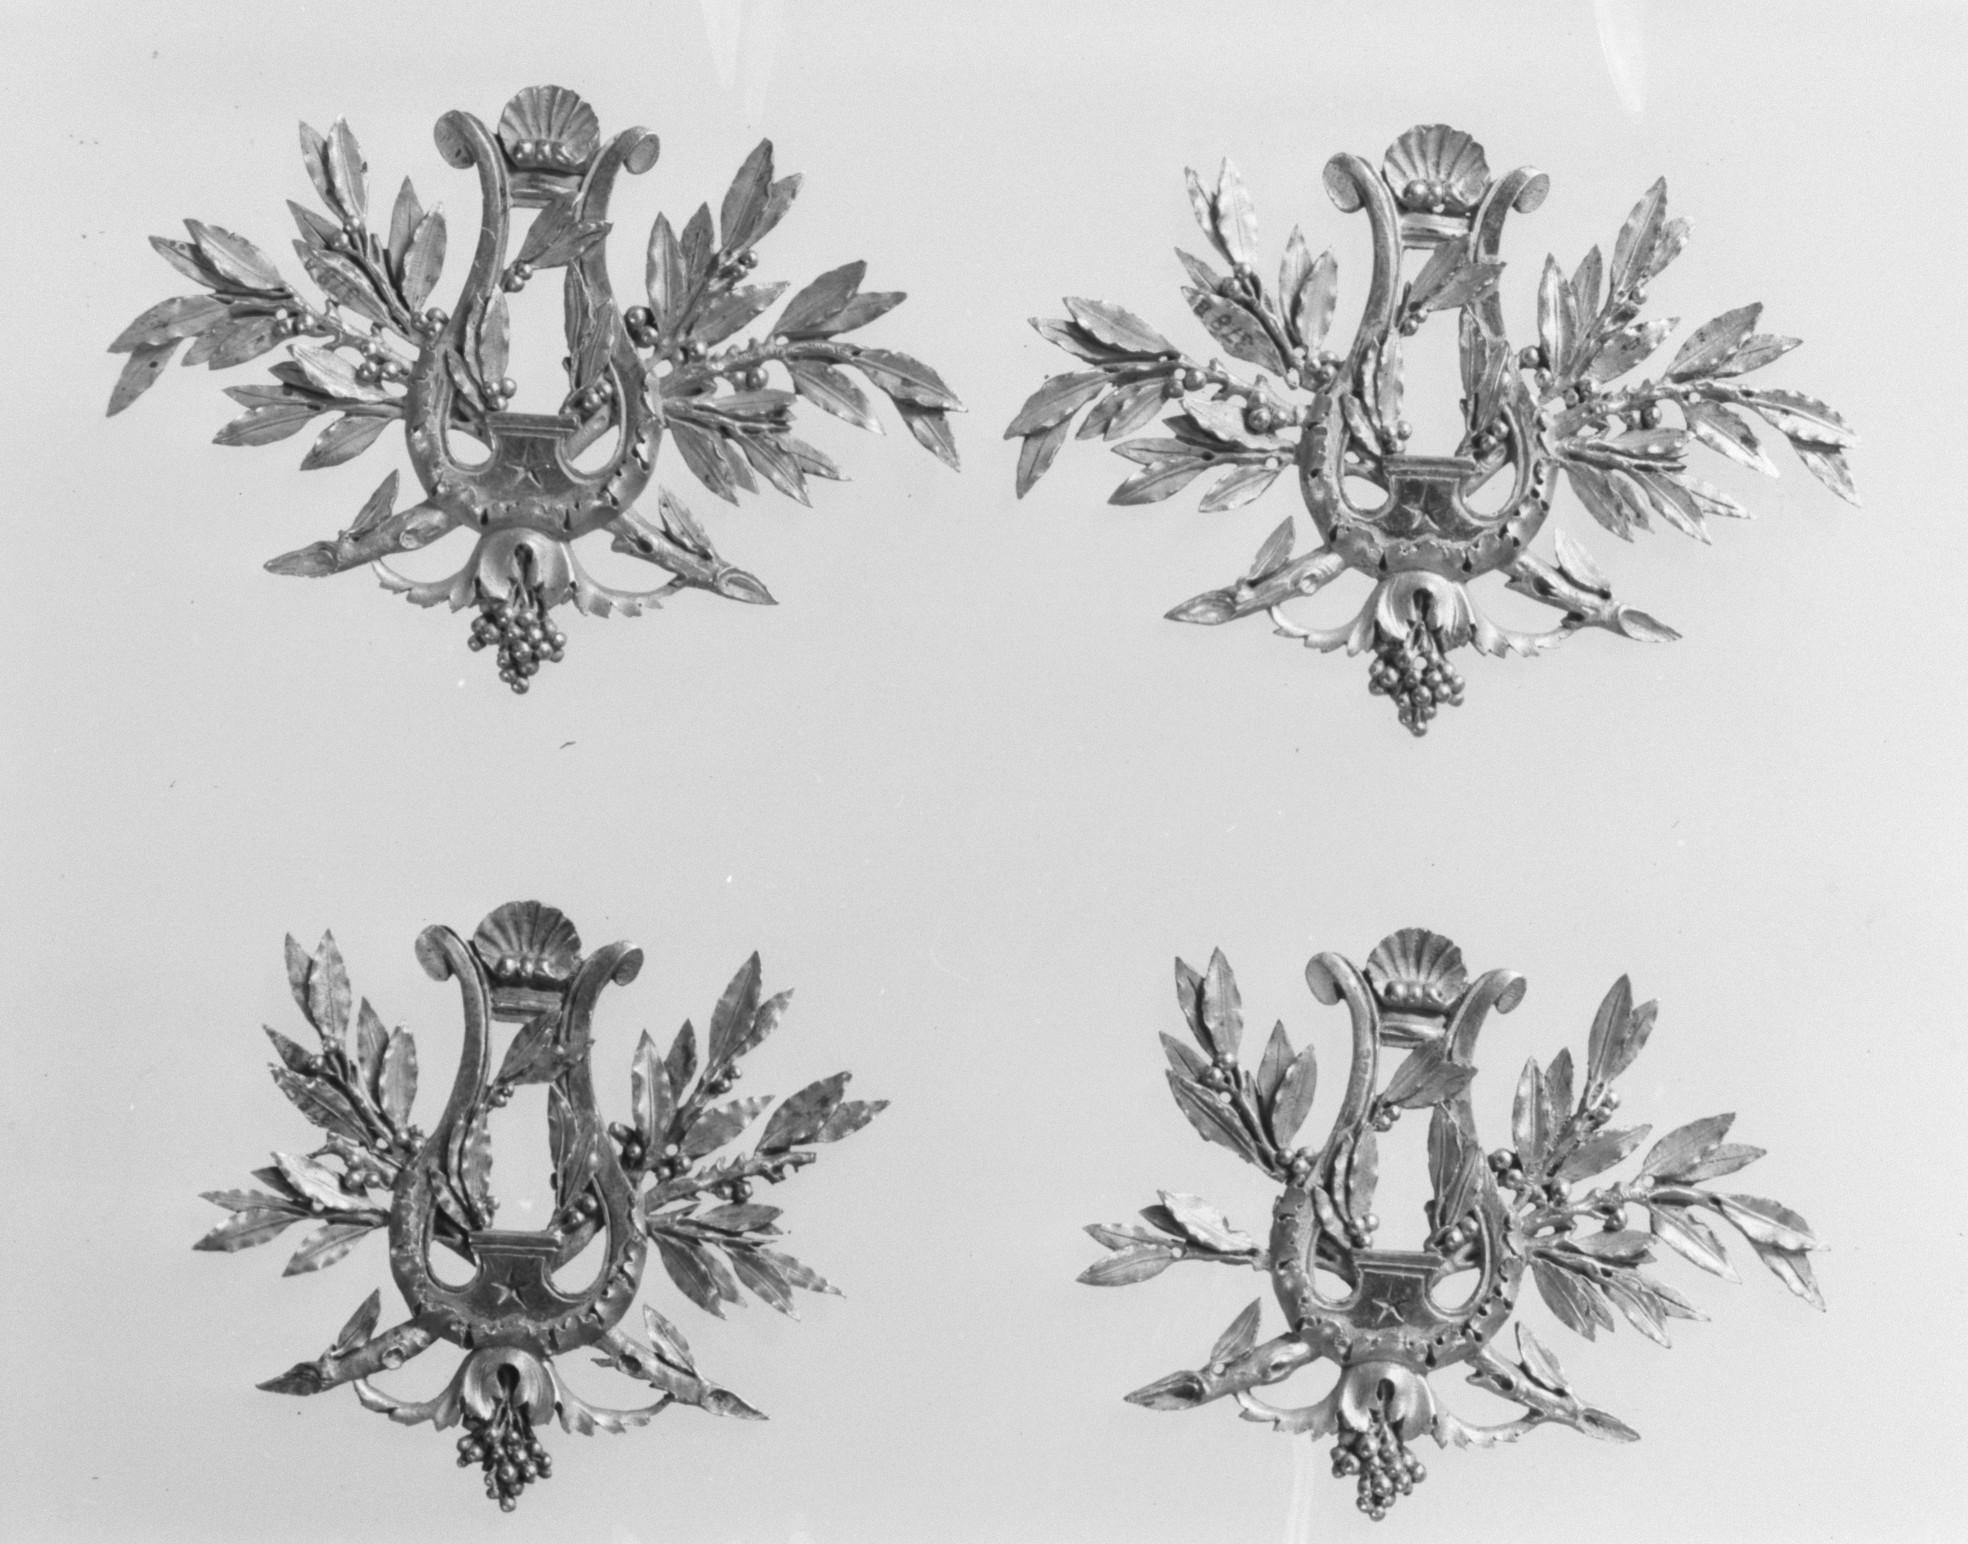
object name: keyhole escutcheon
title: Set of four keyhole escutcheons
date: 1701-1800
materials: gilt bronze